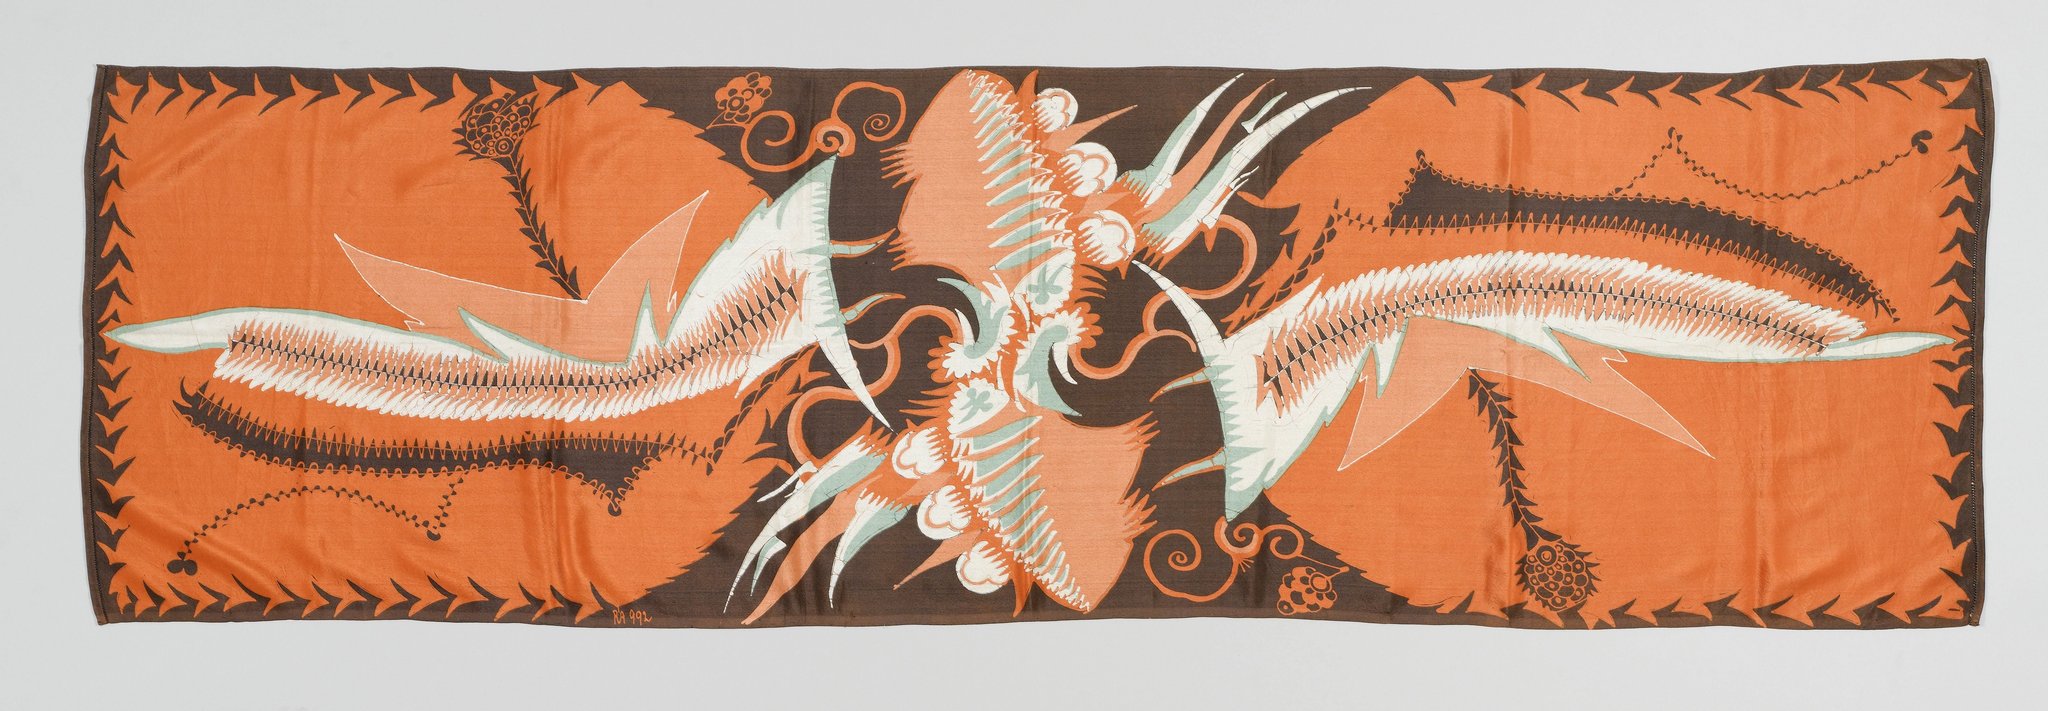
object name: scarf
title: Langwerpige sjaal van zijden crêpe georgette gebatikt in bruin, oranje, groen en beige met een gestileerd floraal motief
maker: ragnhild d ailly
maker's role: batikkunstenaar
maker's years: 1897-1951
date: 1920-1929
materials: ink, silk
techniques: weave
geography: netherlands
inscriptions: monogram: ‘R'A’, number: ‘992’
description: Langwerpige sjaal van zijden crêpe georgette gebatikt in bruin, oranje, groen en beige met een gestileerd floraal motief. De sjaal is aan beide korte kanten voorzien van een plat zoompje met fils-tirés en aan één lange zijde een rolzoompje, aan de andere zijde de zelfkant. Patroon: vanuit een centraal dubbel schildvormig motief een aantal arabesken, die de verbinding vormen met een bladmotief waarin een distel staat.